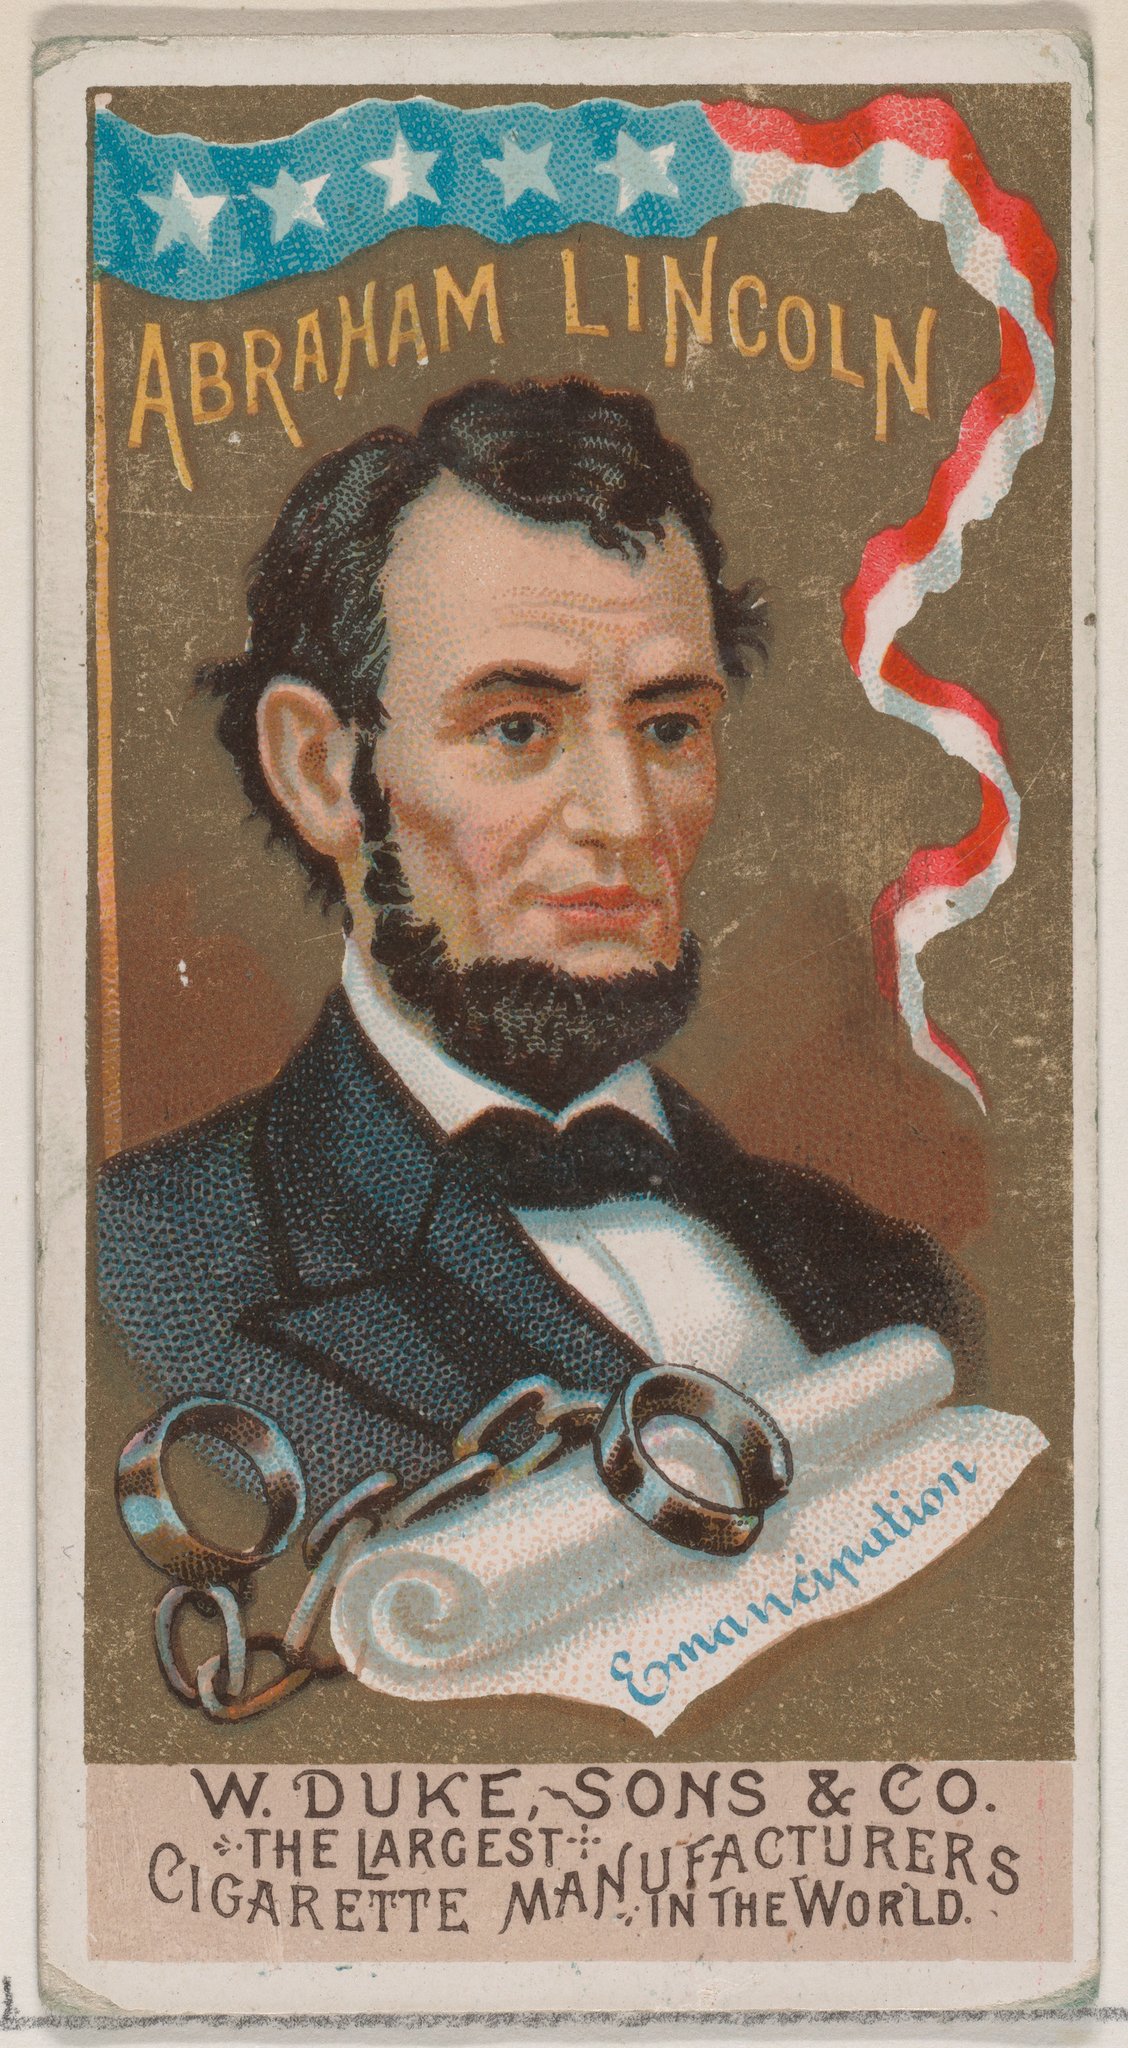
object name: print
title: Abraham Lincoln, from the series Great Americans (N76) for Duke brand cigarettes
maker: w. duke, sons & co.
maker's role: publisher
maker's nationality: american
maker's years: 1870-1920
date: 1888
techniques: color lithograph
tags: abraham lincoln,men